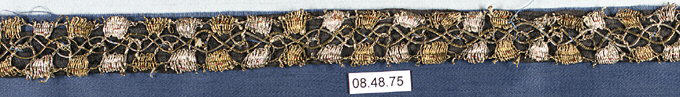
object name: strip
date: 1601-1700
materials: silk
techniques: lace